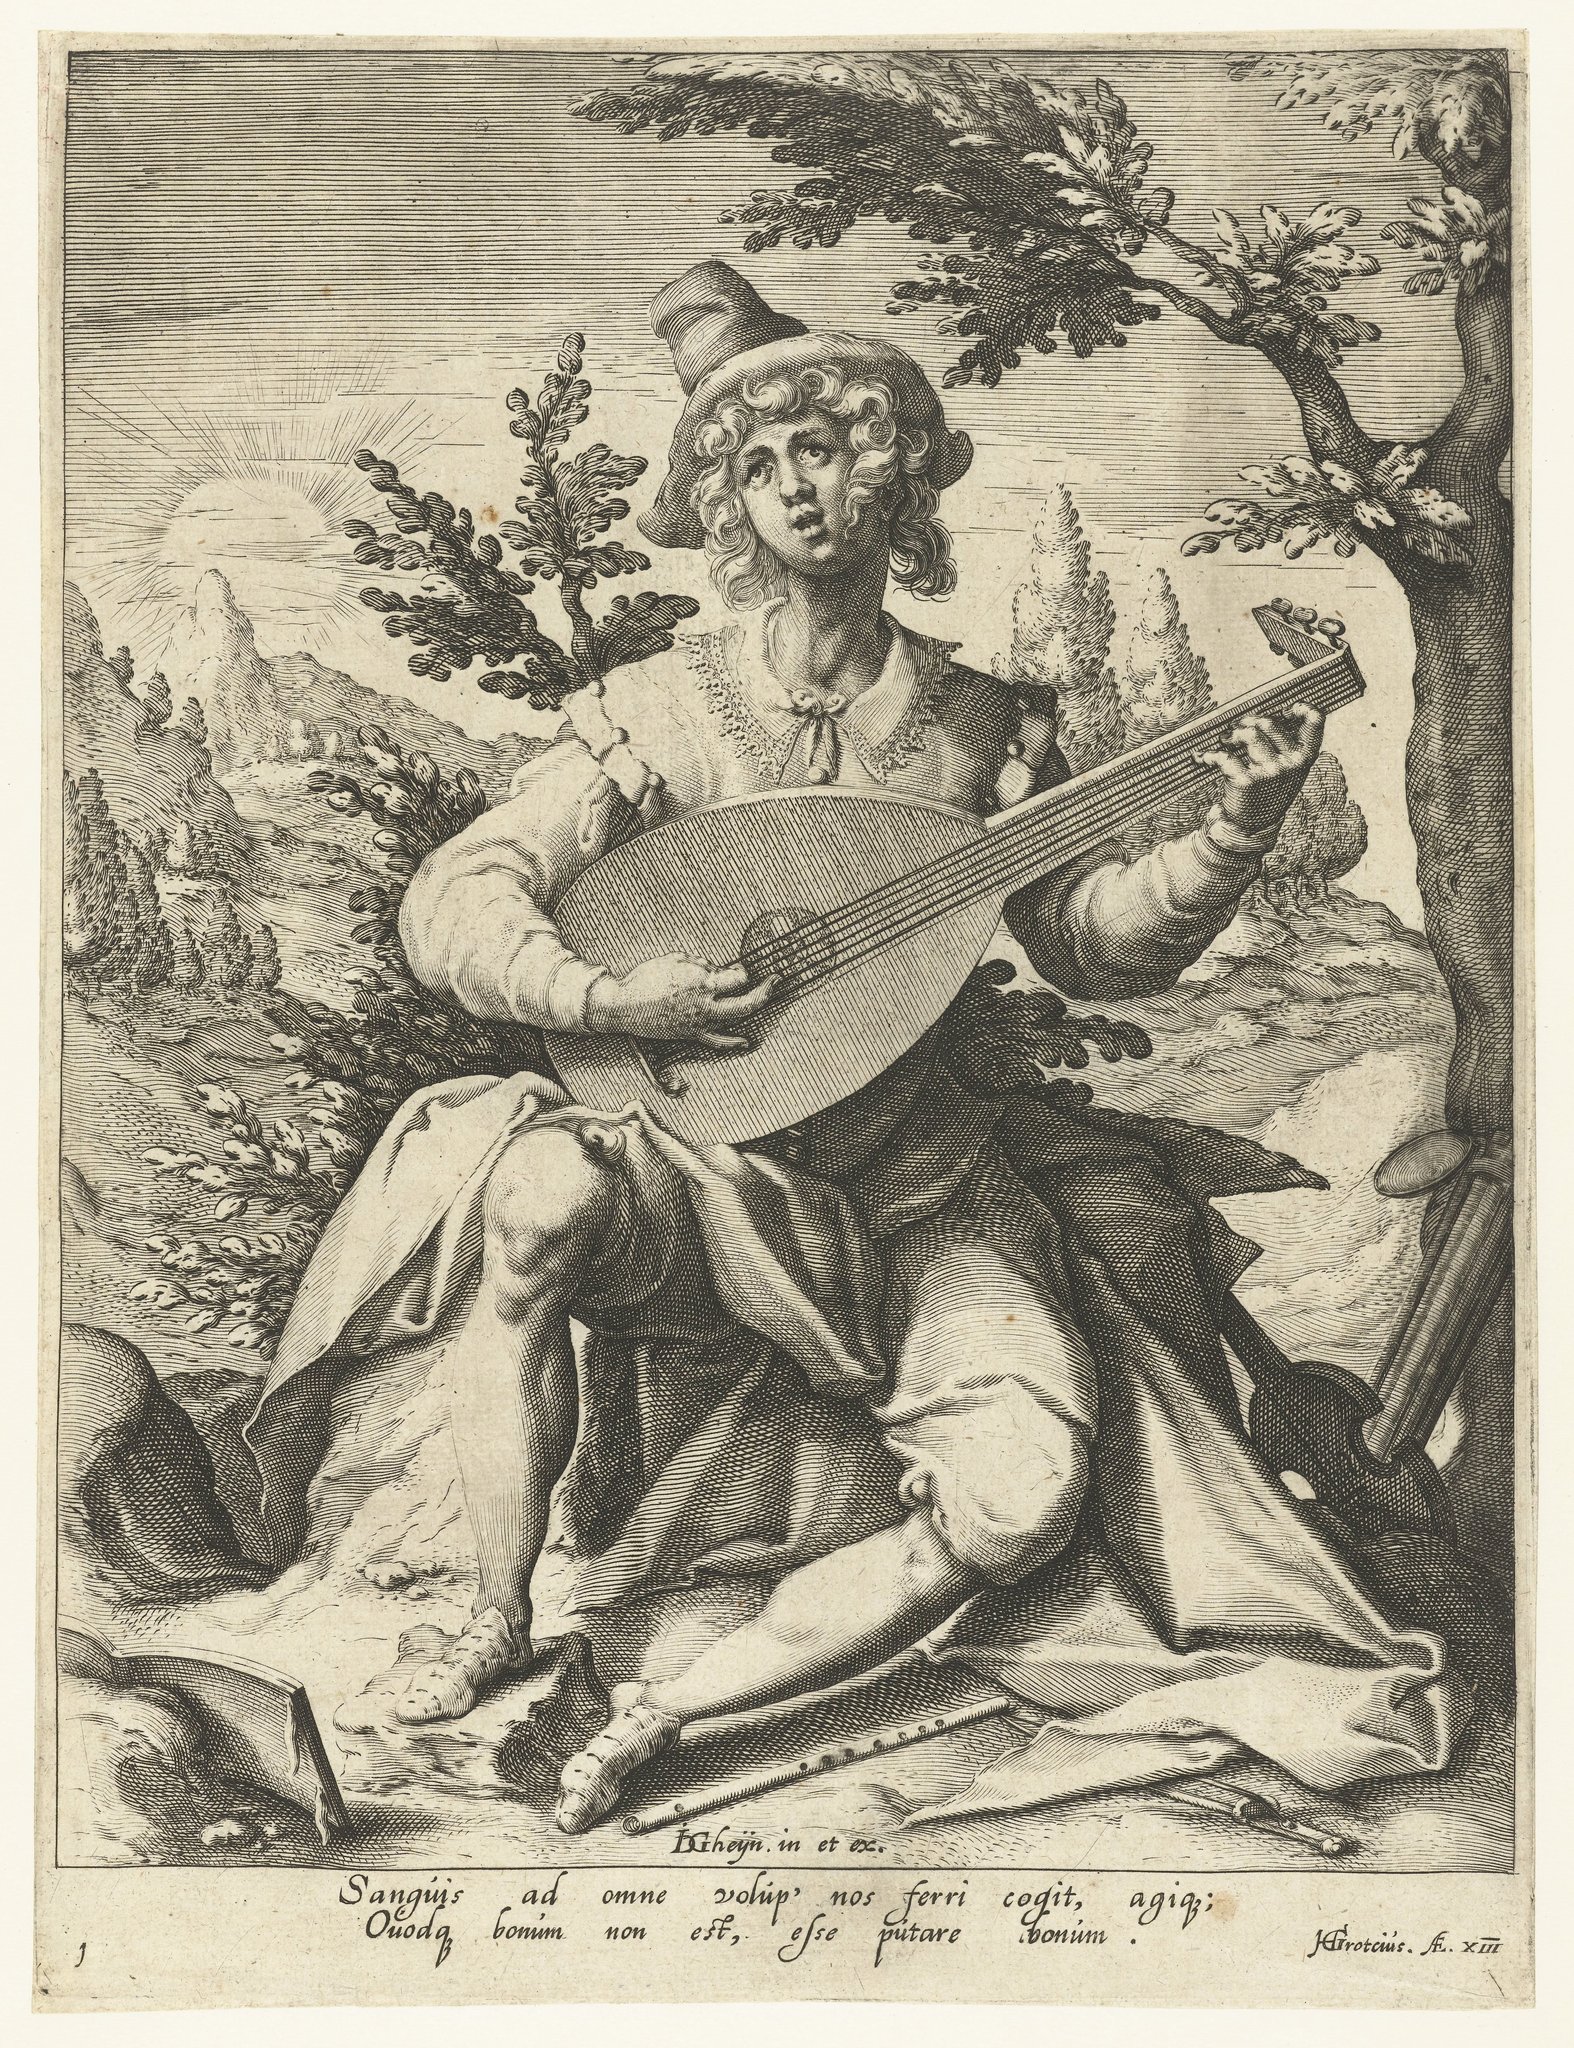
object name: print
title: De vier temperamenten (verbonden met de vier elementen)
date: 1596-1597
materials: paper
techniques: engraving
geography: leiden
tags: air (one of the four elements), one person playing string instrument (plucked), lute, and special forms of lute, e.g.: theorbo, sanguine temperament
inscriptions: collector's mark: Lugt 2228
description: Voorstelling van het sanguinische temperament in de vorm van een jeugdige man (een muzikant), in een lieflijk landschap bij opkomende zon spelend op een luit, een muziekboek, een fluit en een strijkstok aan zijn voeten. Onder de voorstelling twee regels tekst in Latijn. Deze prent is onderdeel van een serie van de vier temperamenten, elk verbeeld door een figuur ten voeten uit, verwikkeld in een handeling en zittend/staand in een omgeving die geassocieerd wordt met een van de vier elementen. Elke voorstelling heeft een tweeregelig Latijns onderschrift.